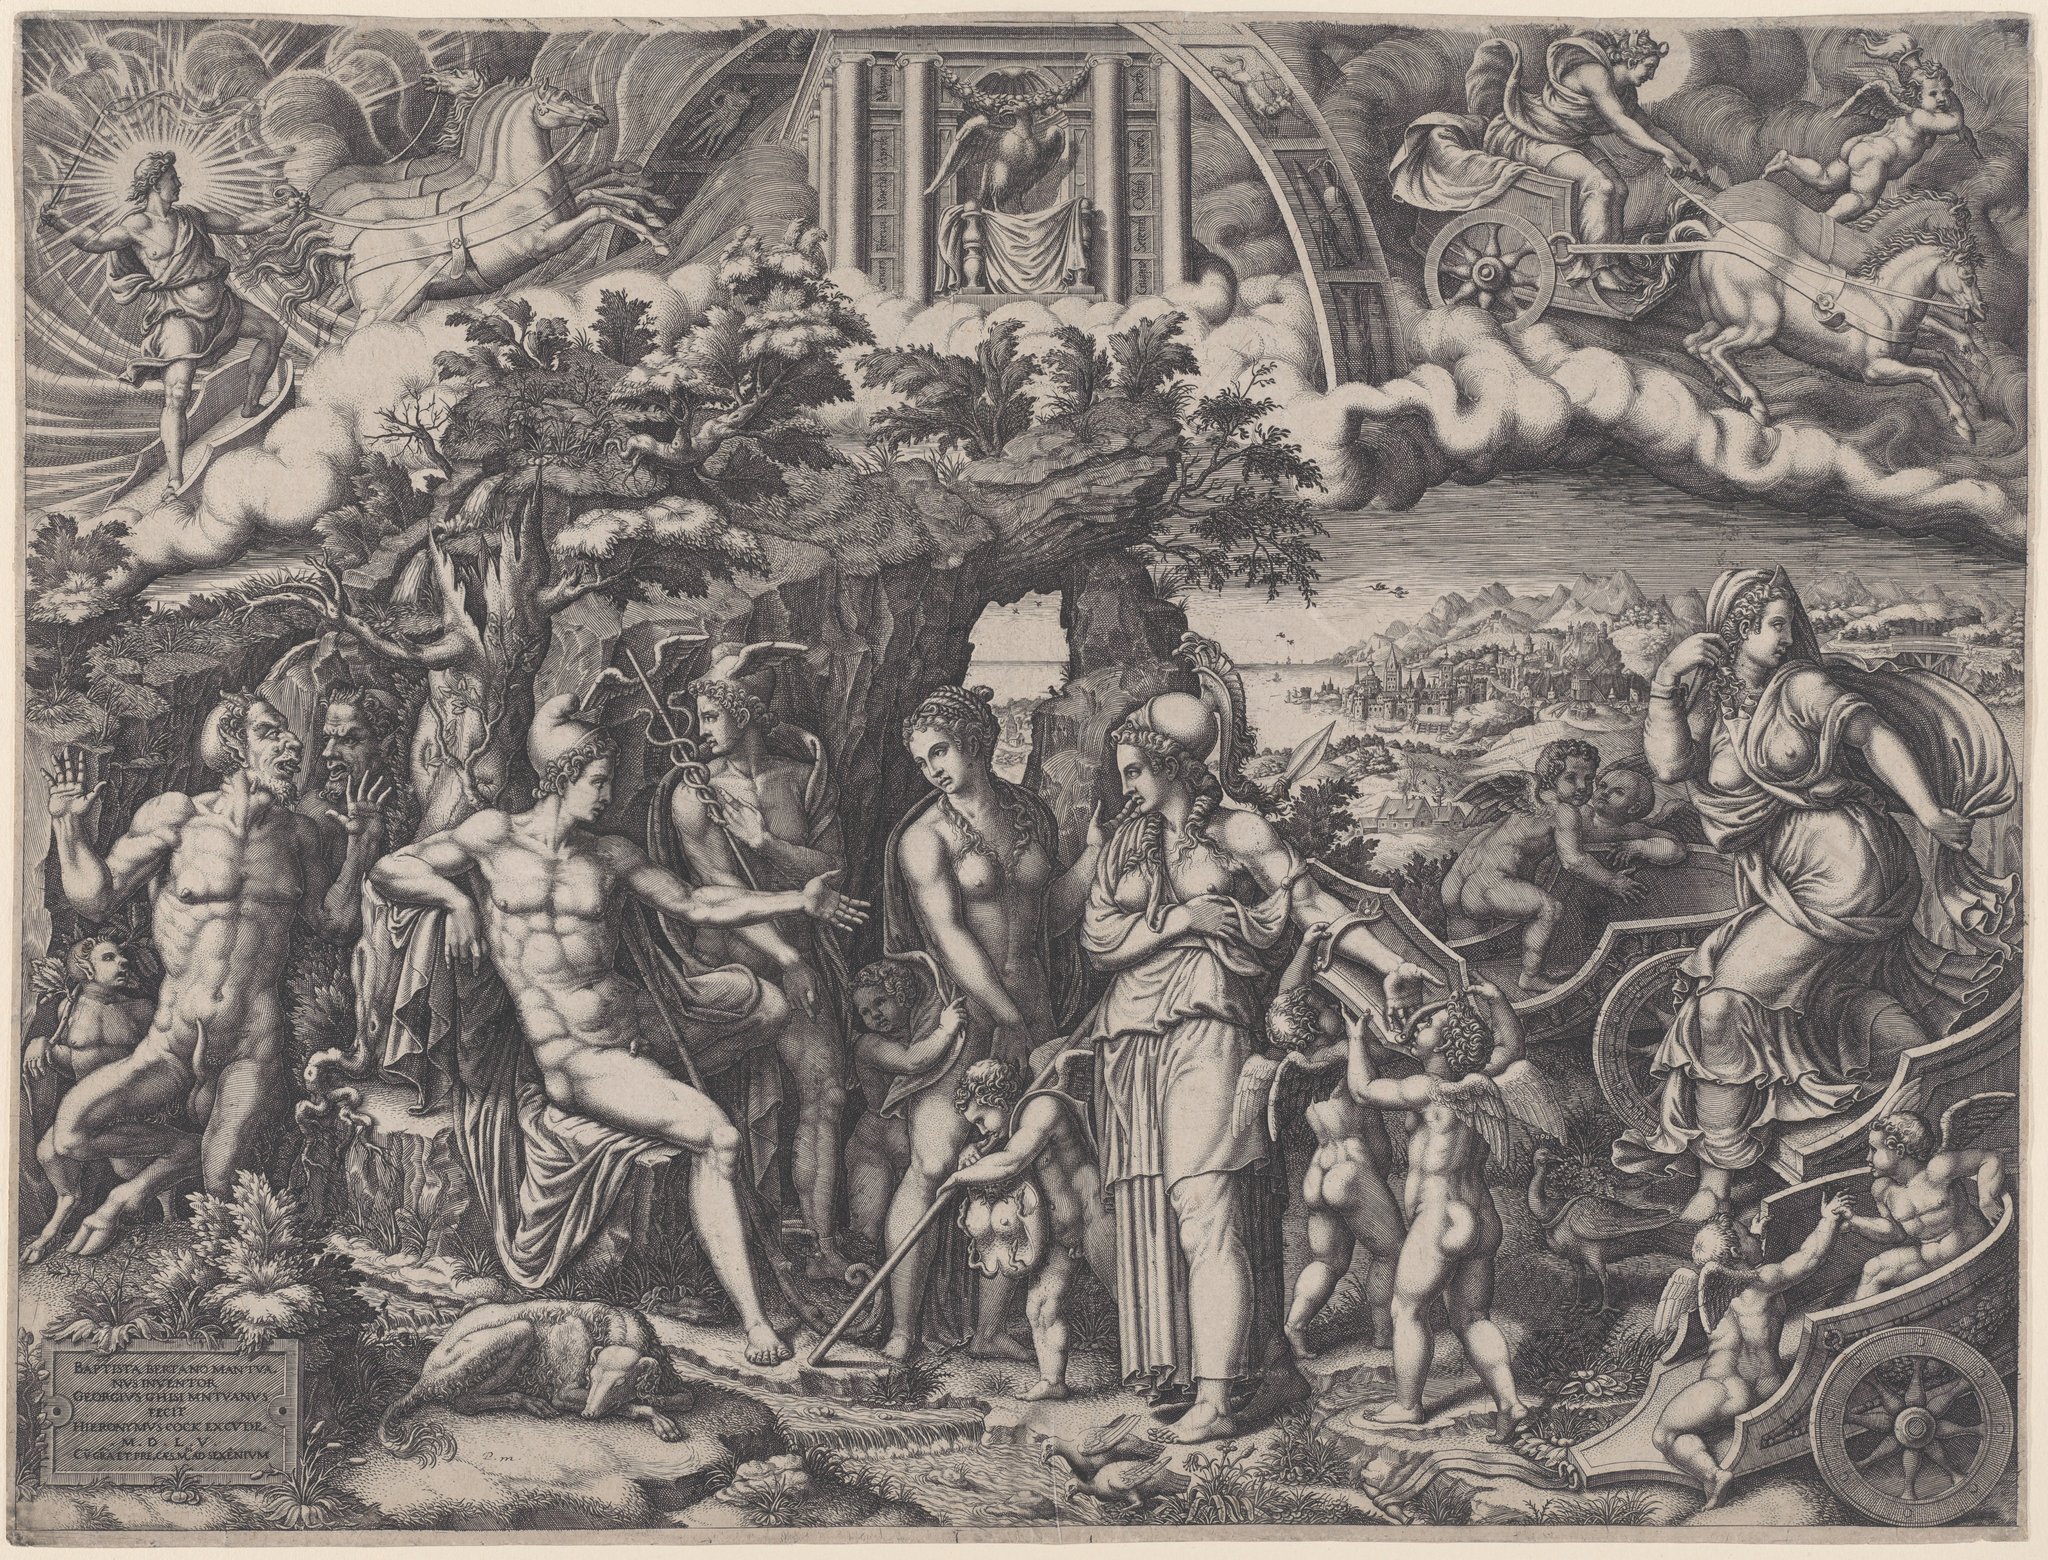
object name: print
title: The Judgment of Paris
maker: giorgio ghisi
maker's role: artist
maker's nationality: italian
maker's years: 1515-1582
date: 1555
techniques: engraving